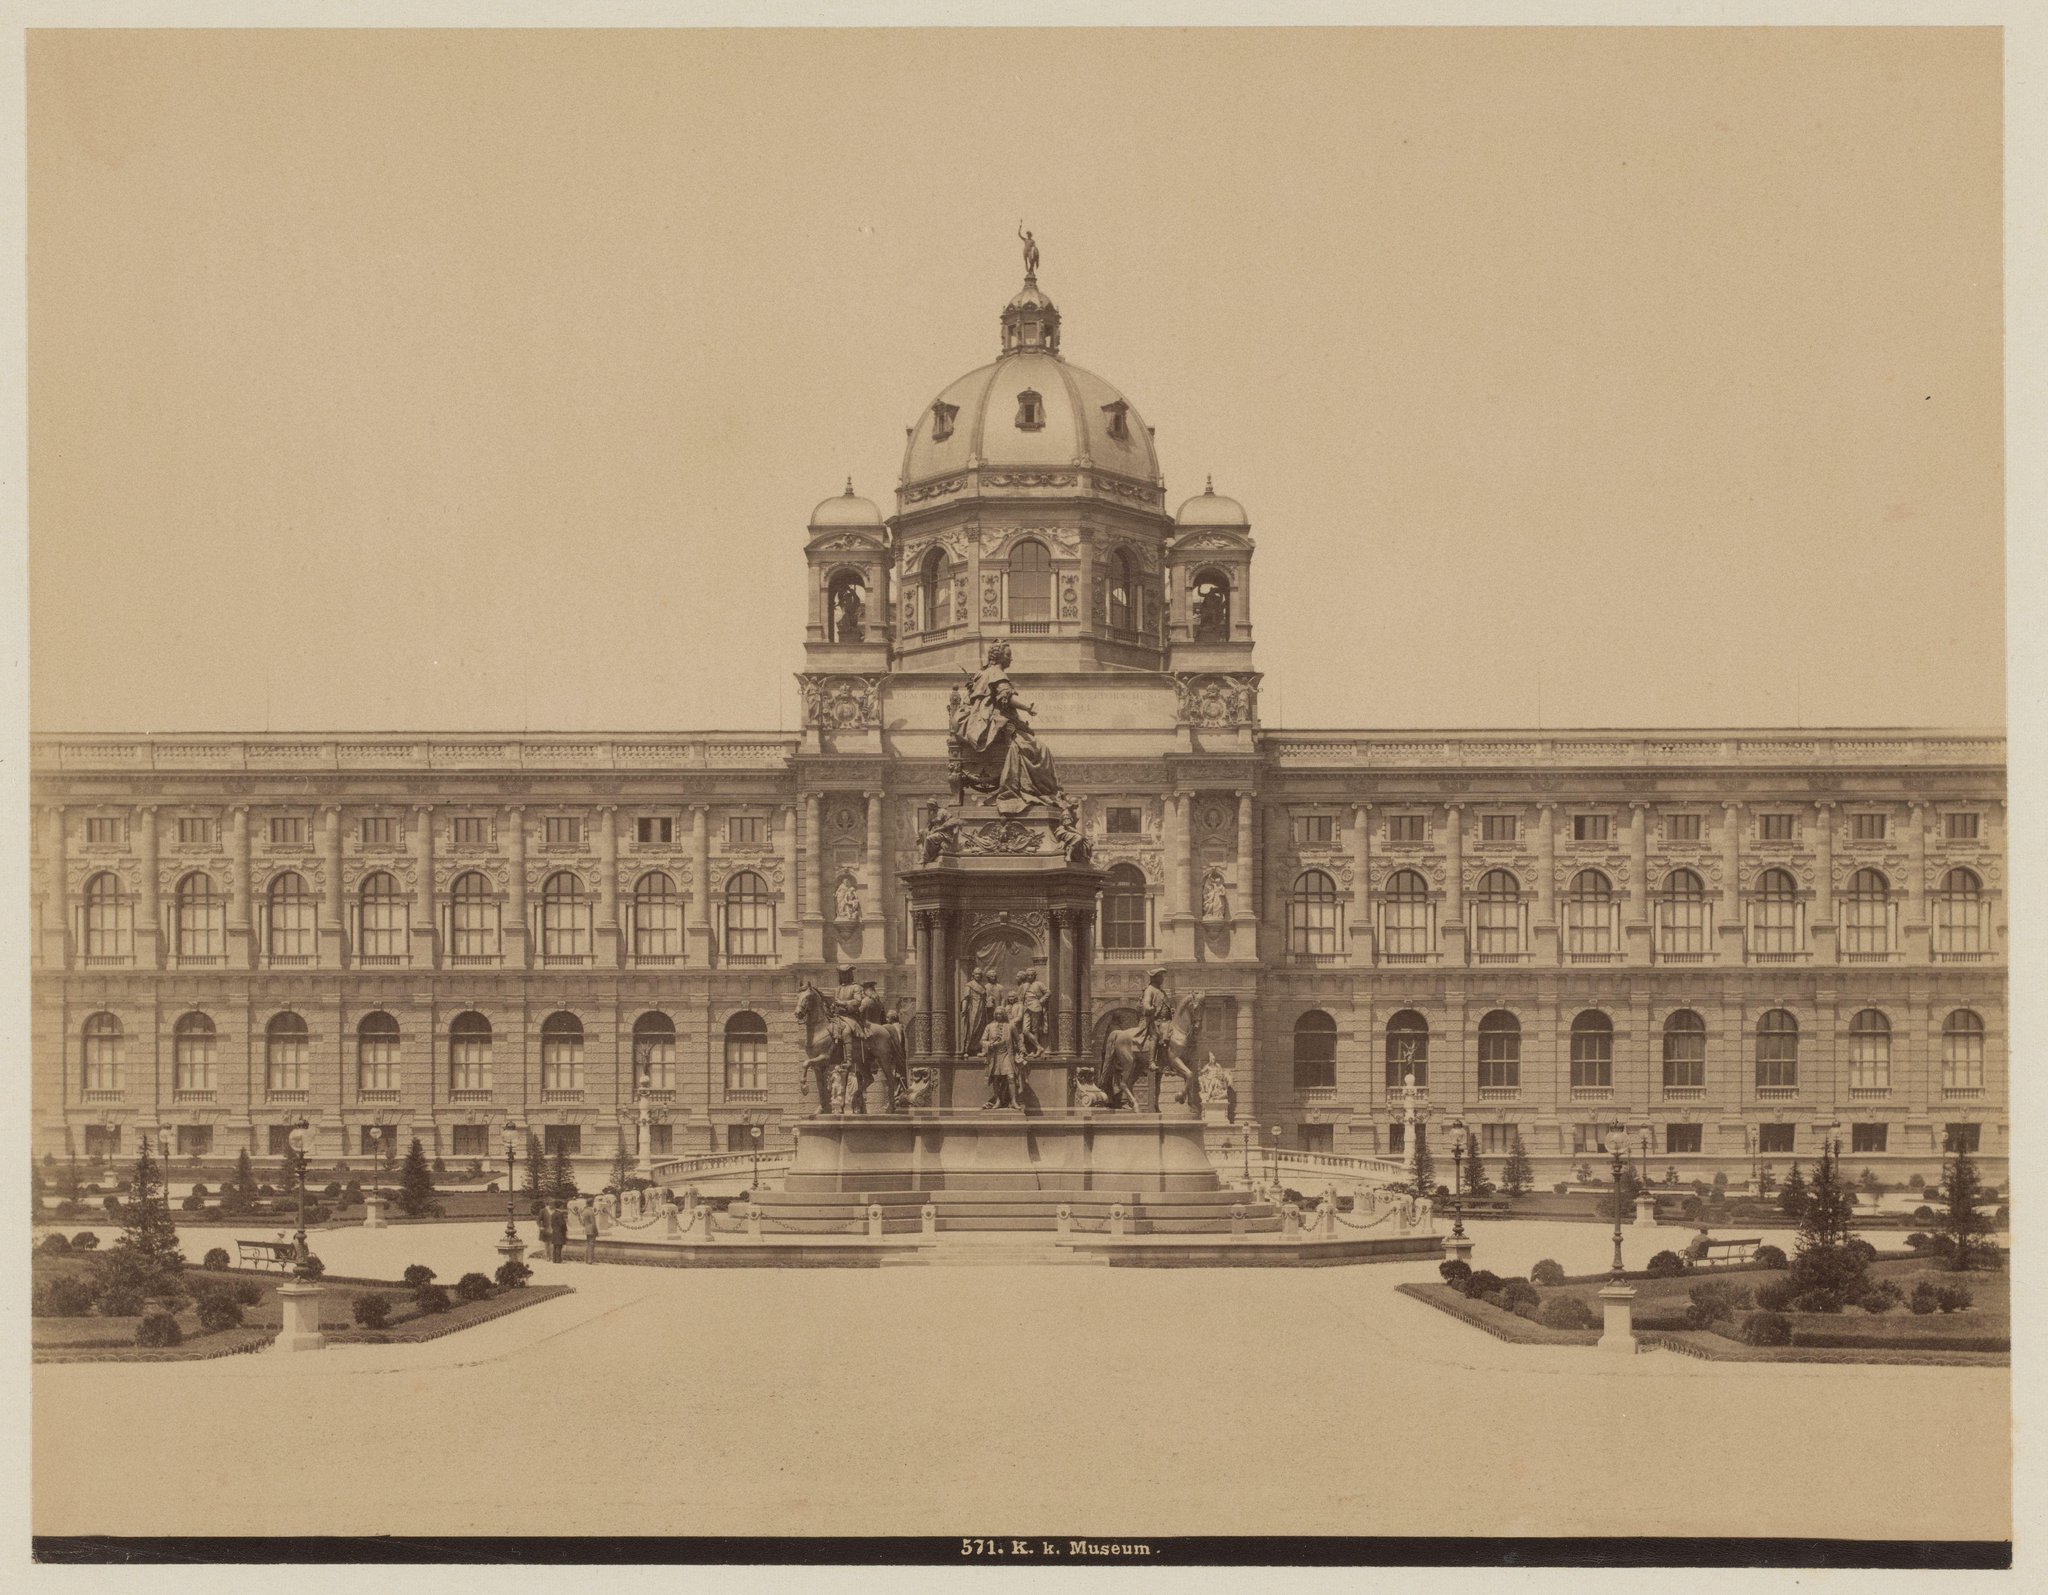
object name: photograph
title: K.K. Museum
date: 1889-1900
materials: cardboard, paper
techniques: albumen print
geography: vienna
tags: permanent exhibition, museum, exterior ~ representation of a building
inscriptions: number: ‘571.’